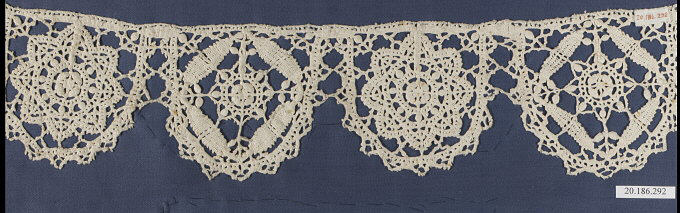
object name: edging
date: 1601-1700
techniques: lace